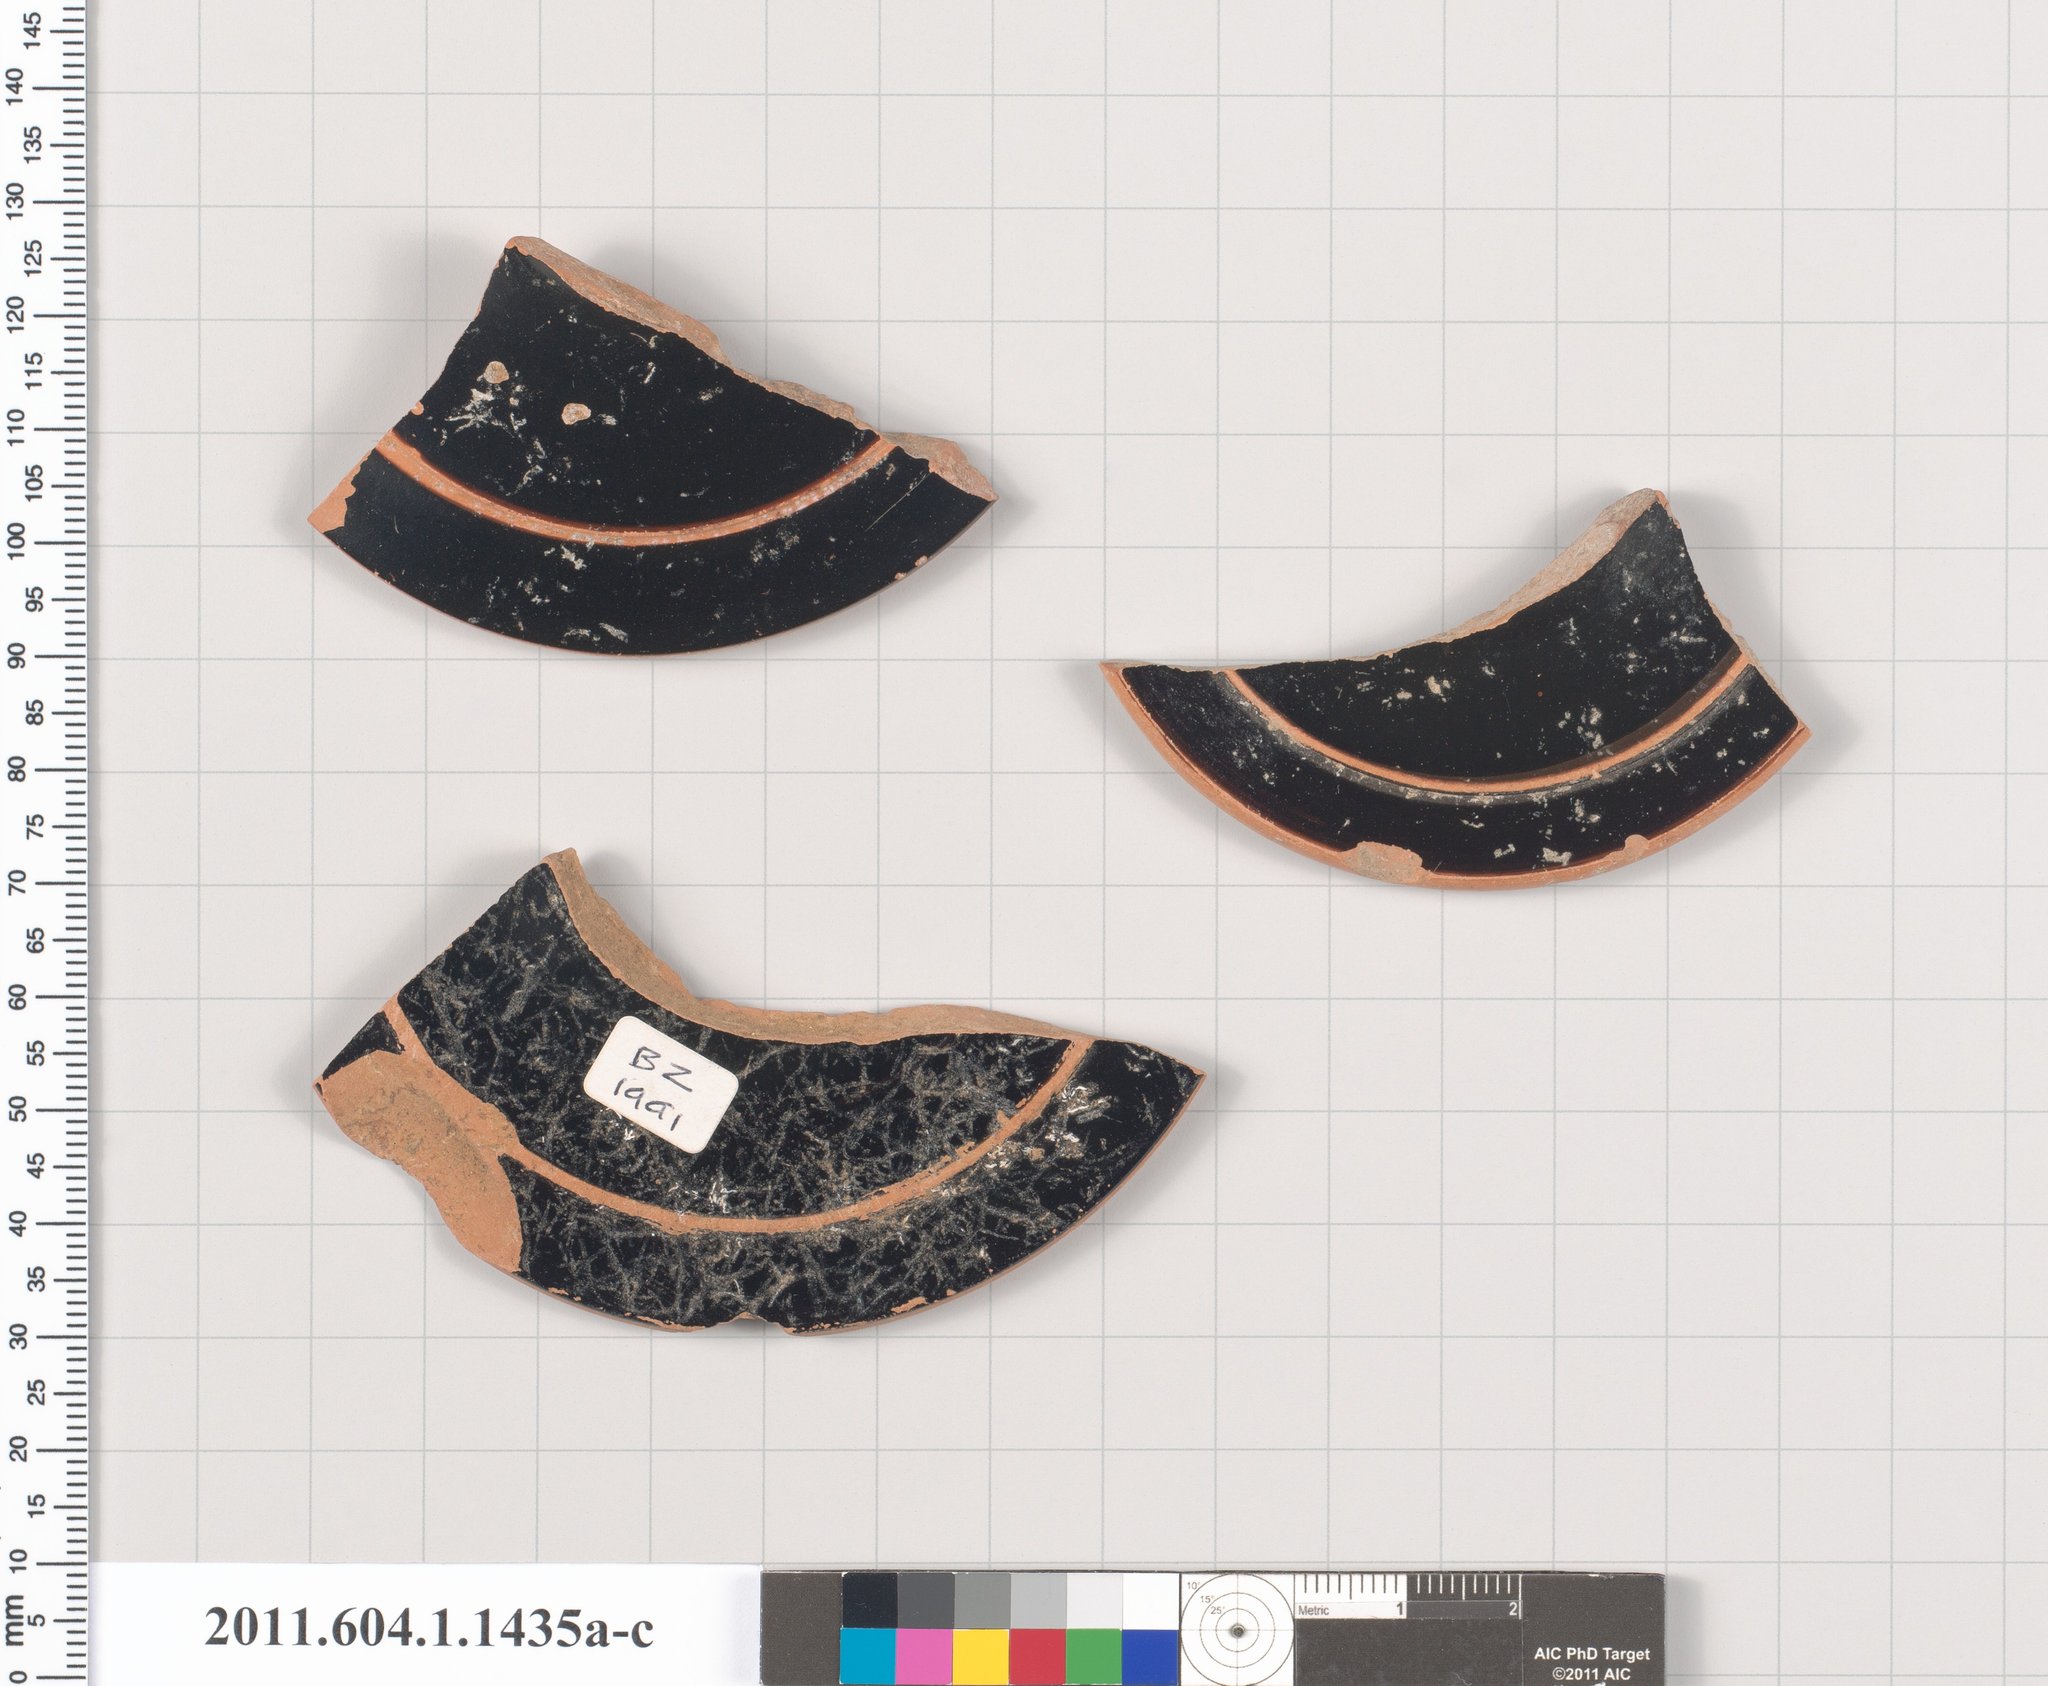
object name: kylix fragment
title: Terracotta fragments of kylikes (drinking cups)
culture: greek, attic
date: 500-401 BCE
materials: terracotta